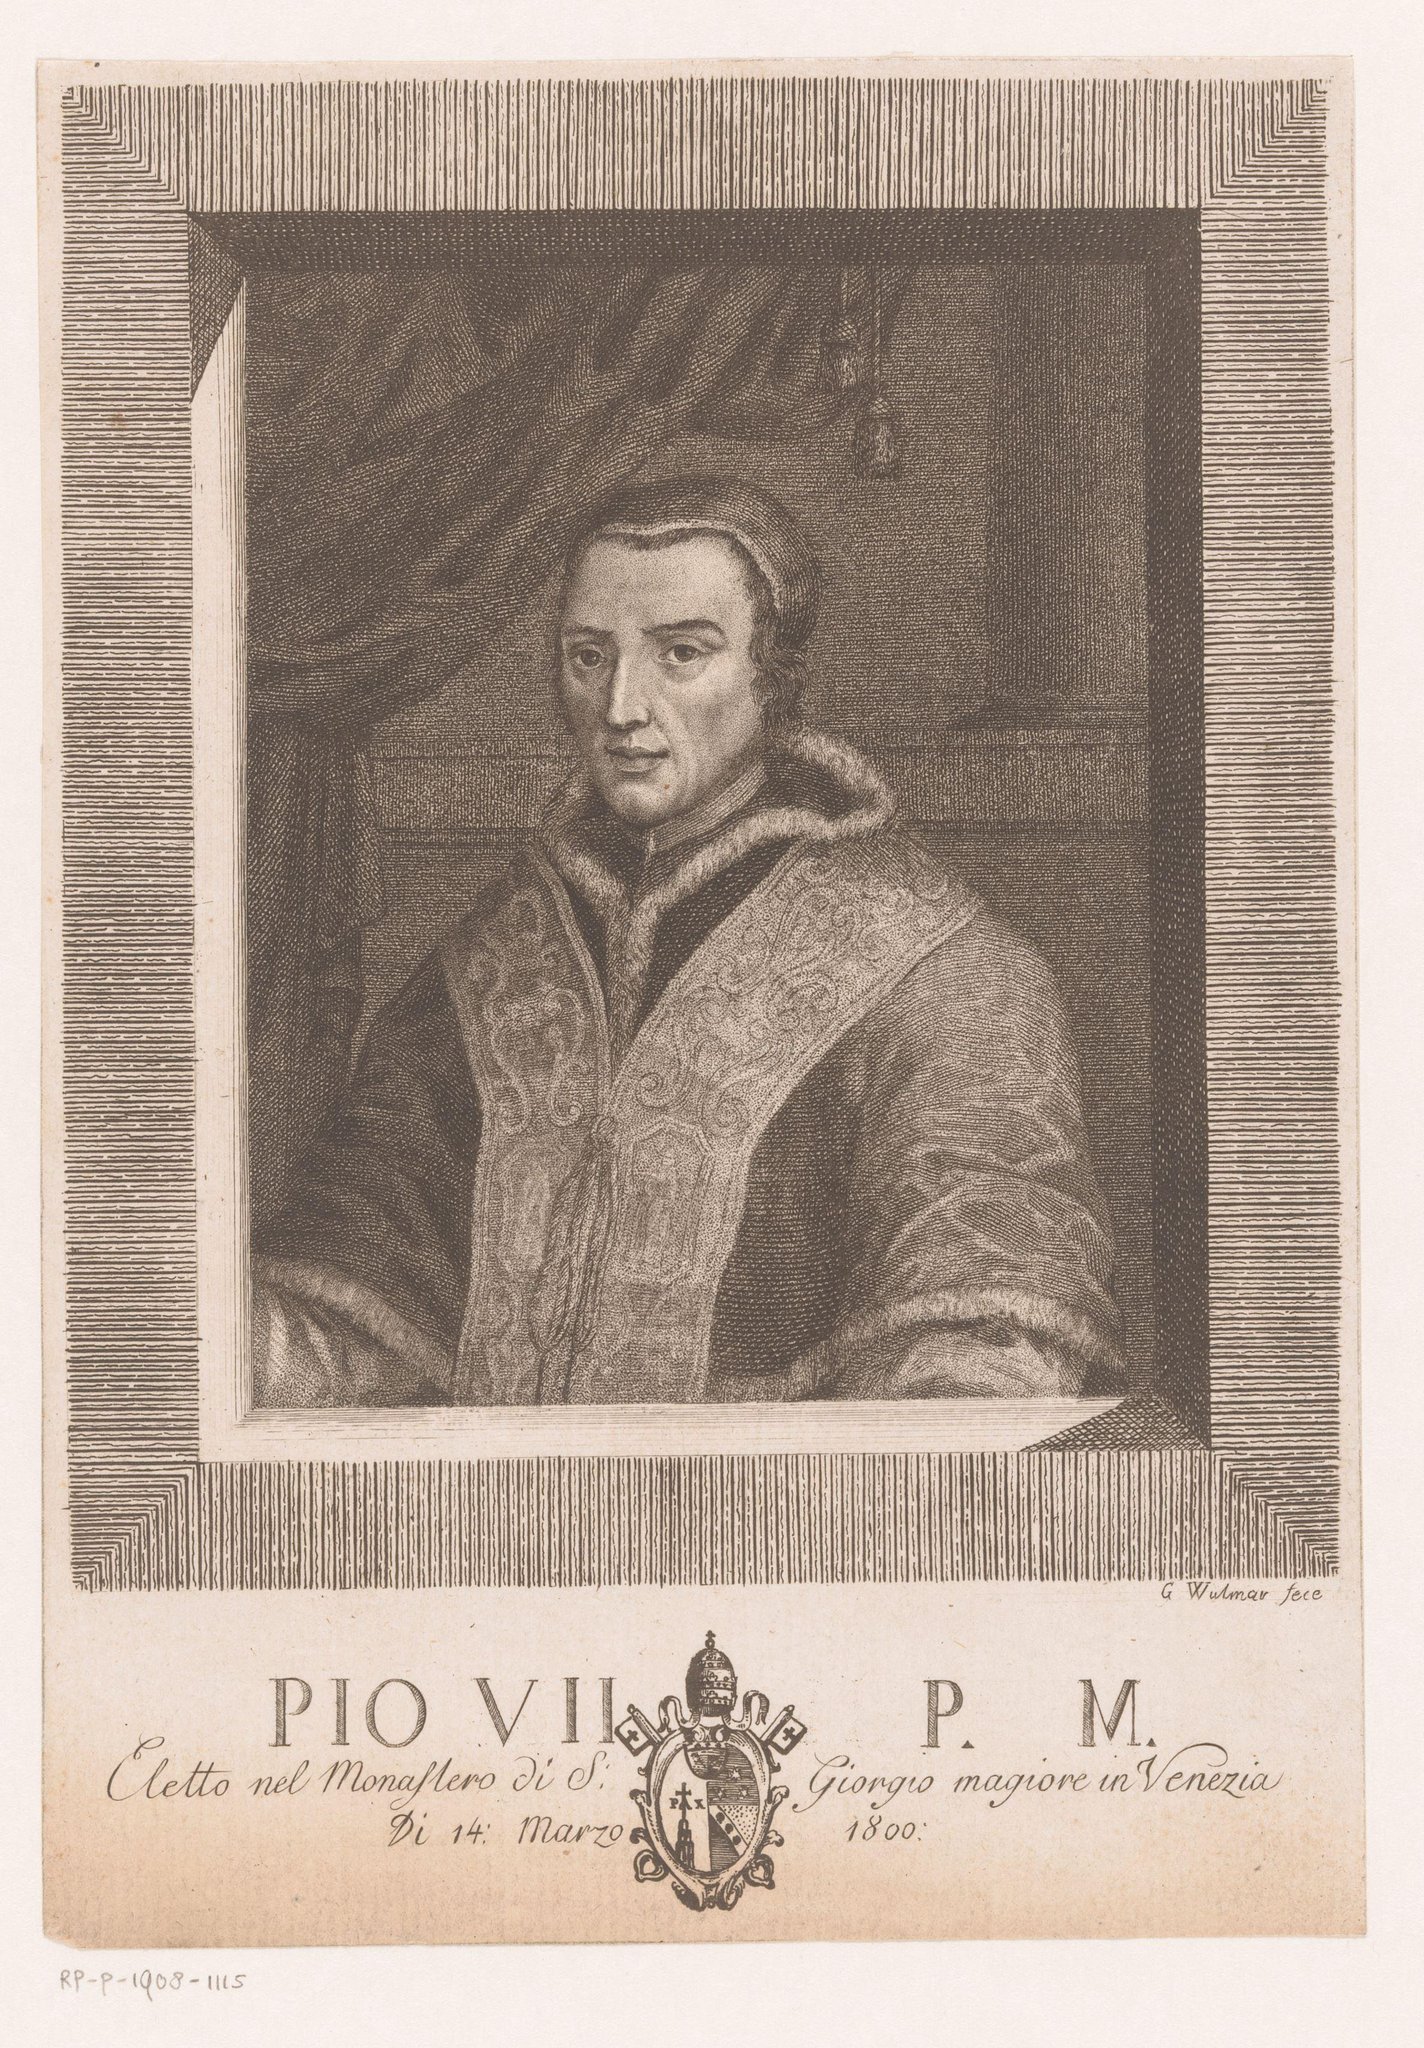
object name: print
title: Portret van paus Pius VII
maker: g. wulmar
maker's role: print maker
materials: paper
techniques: engraving, etching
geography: germany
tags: clergyman, pius vii, historical persons, pope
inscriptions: collector's mark: Lugt 2228